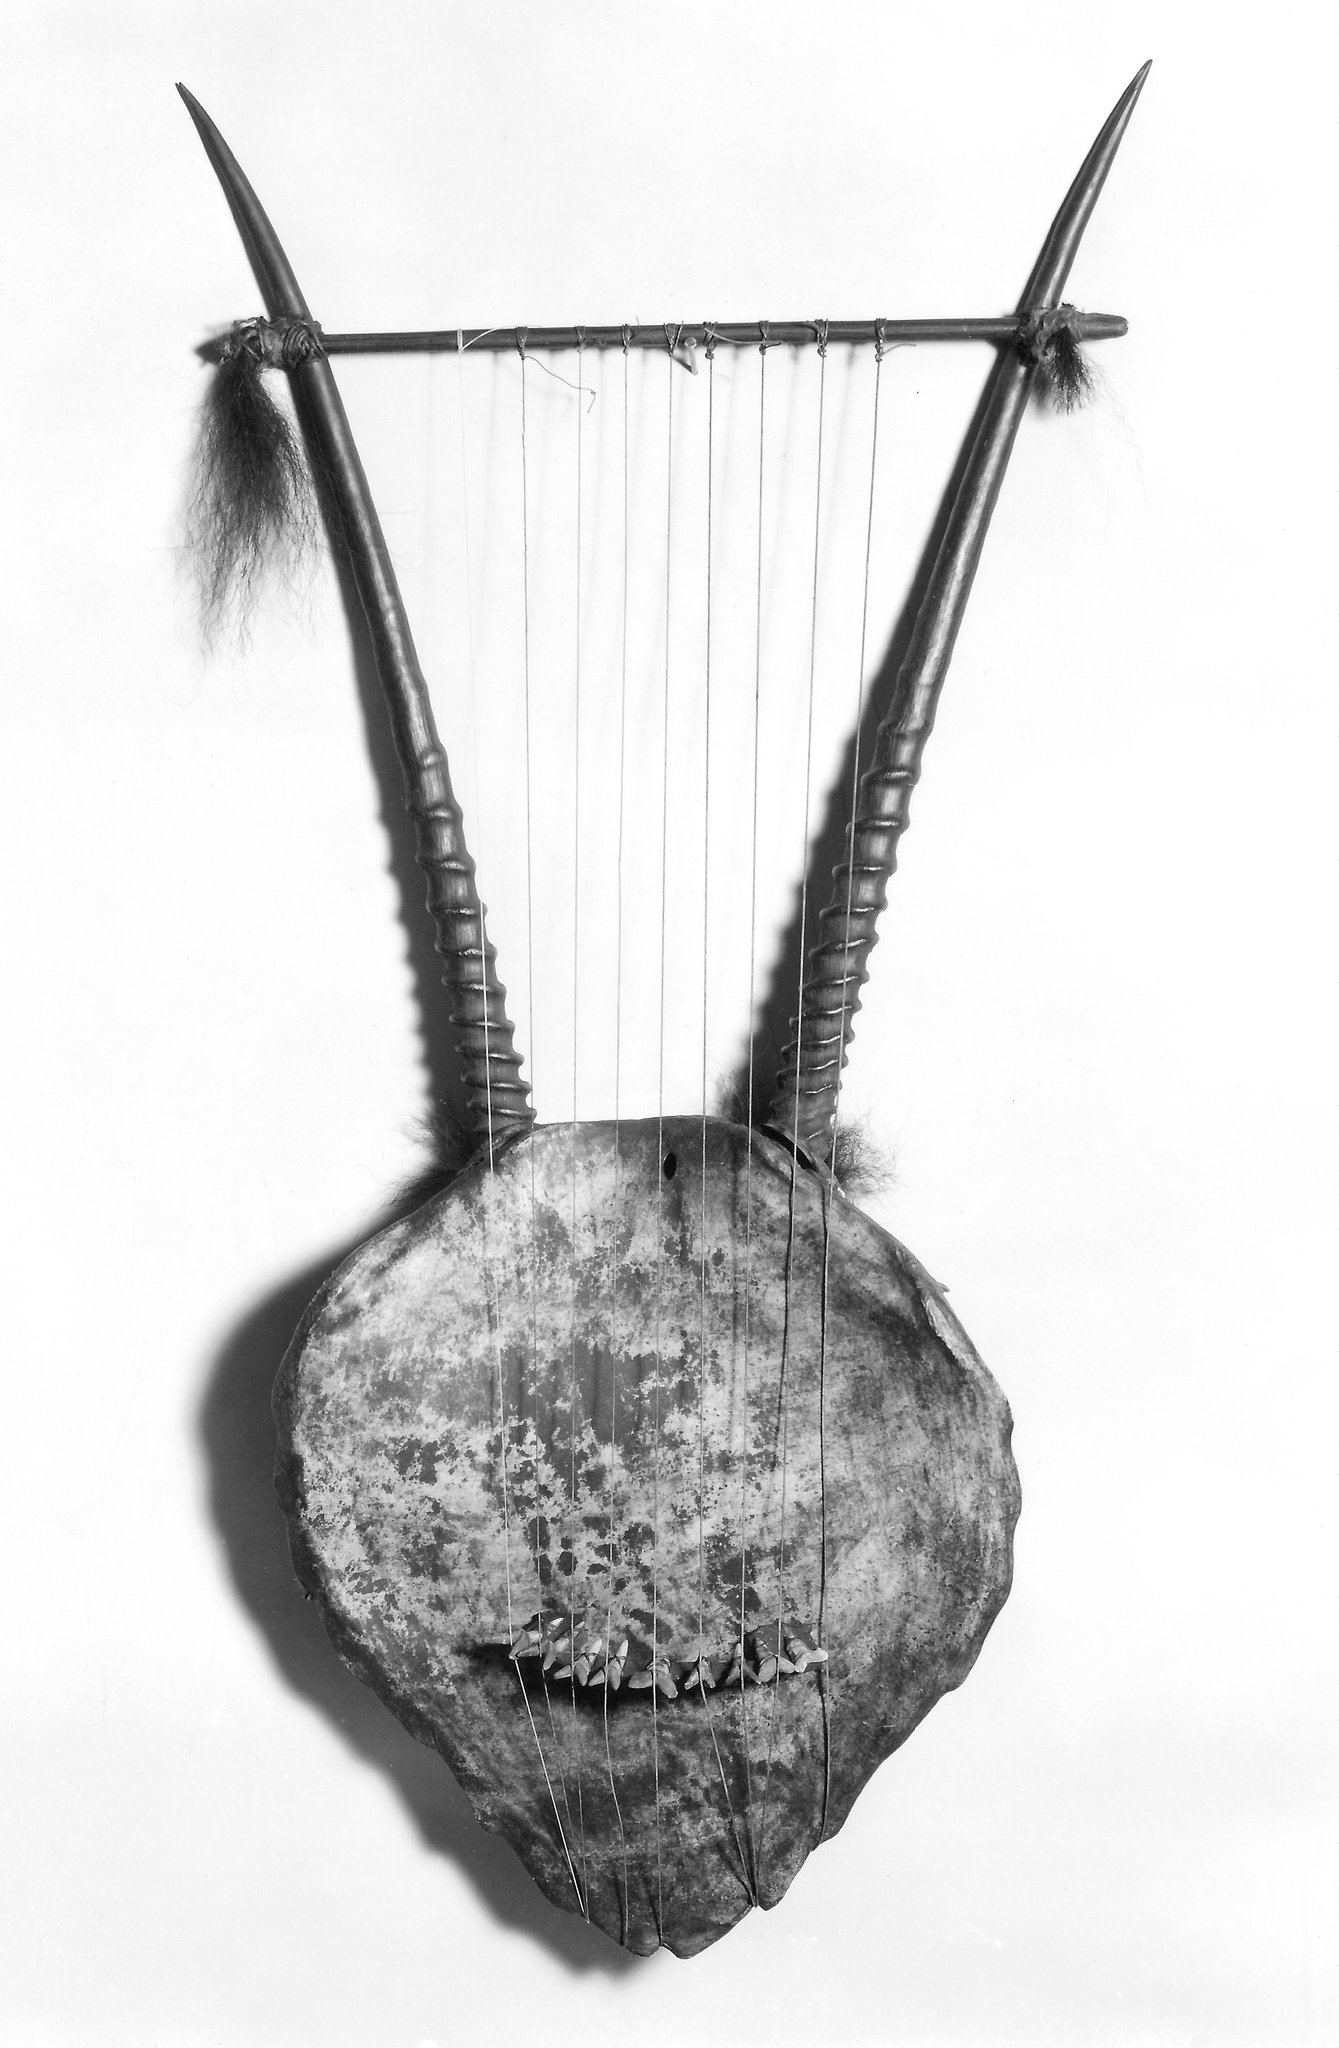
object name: lyre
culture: african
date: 1801-1900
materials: hemp, shell